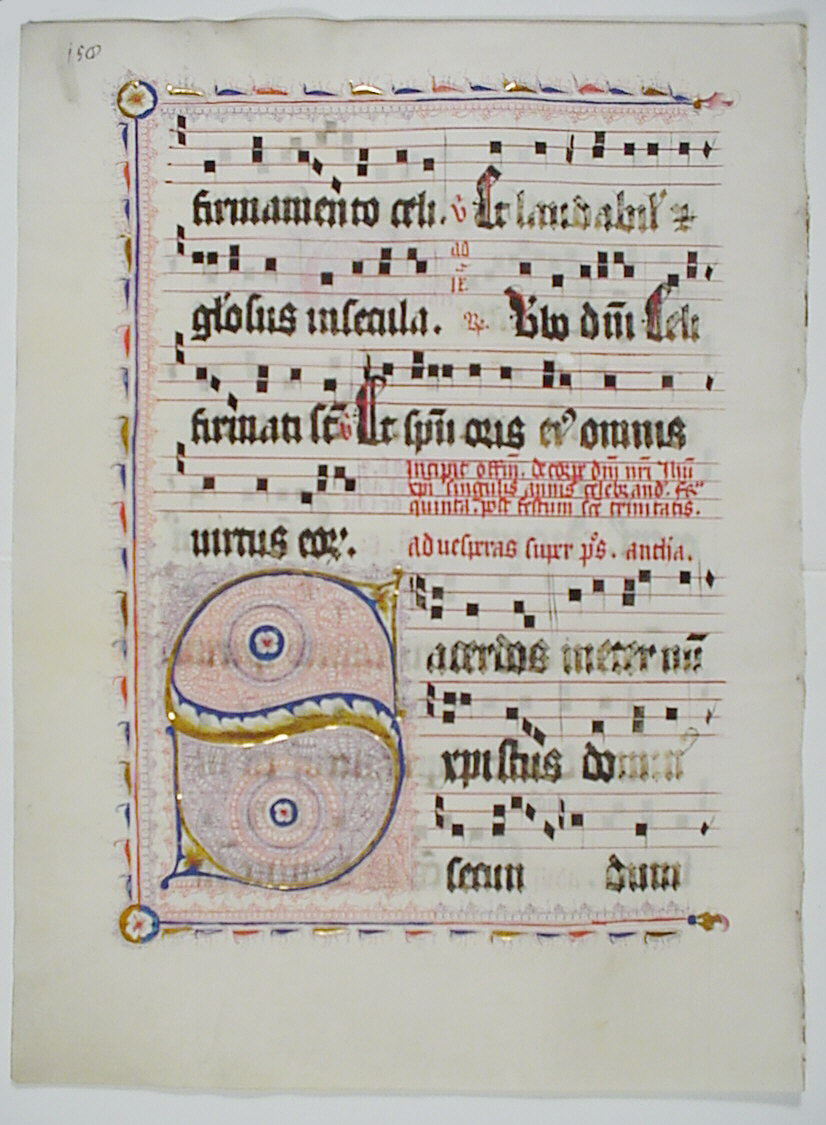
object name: antiphonary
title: Manuscript Leaf with Initial S, from an Antiphonary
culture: german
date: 1426-1450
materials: ink, metal leaf, parchment, paint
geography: germany